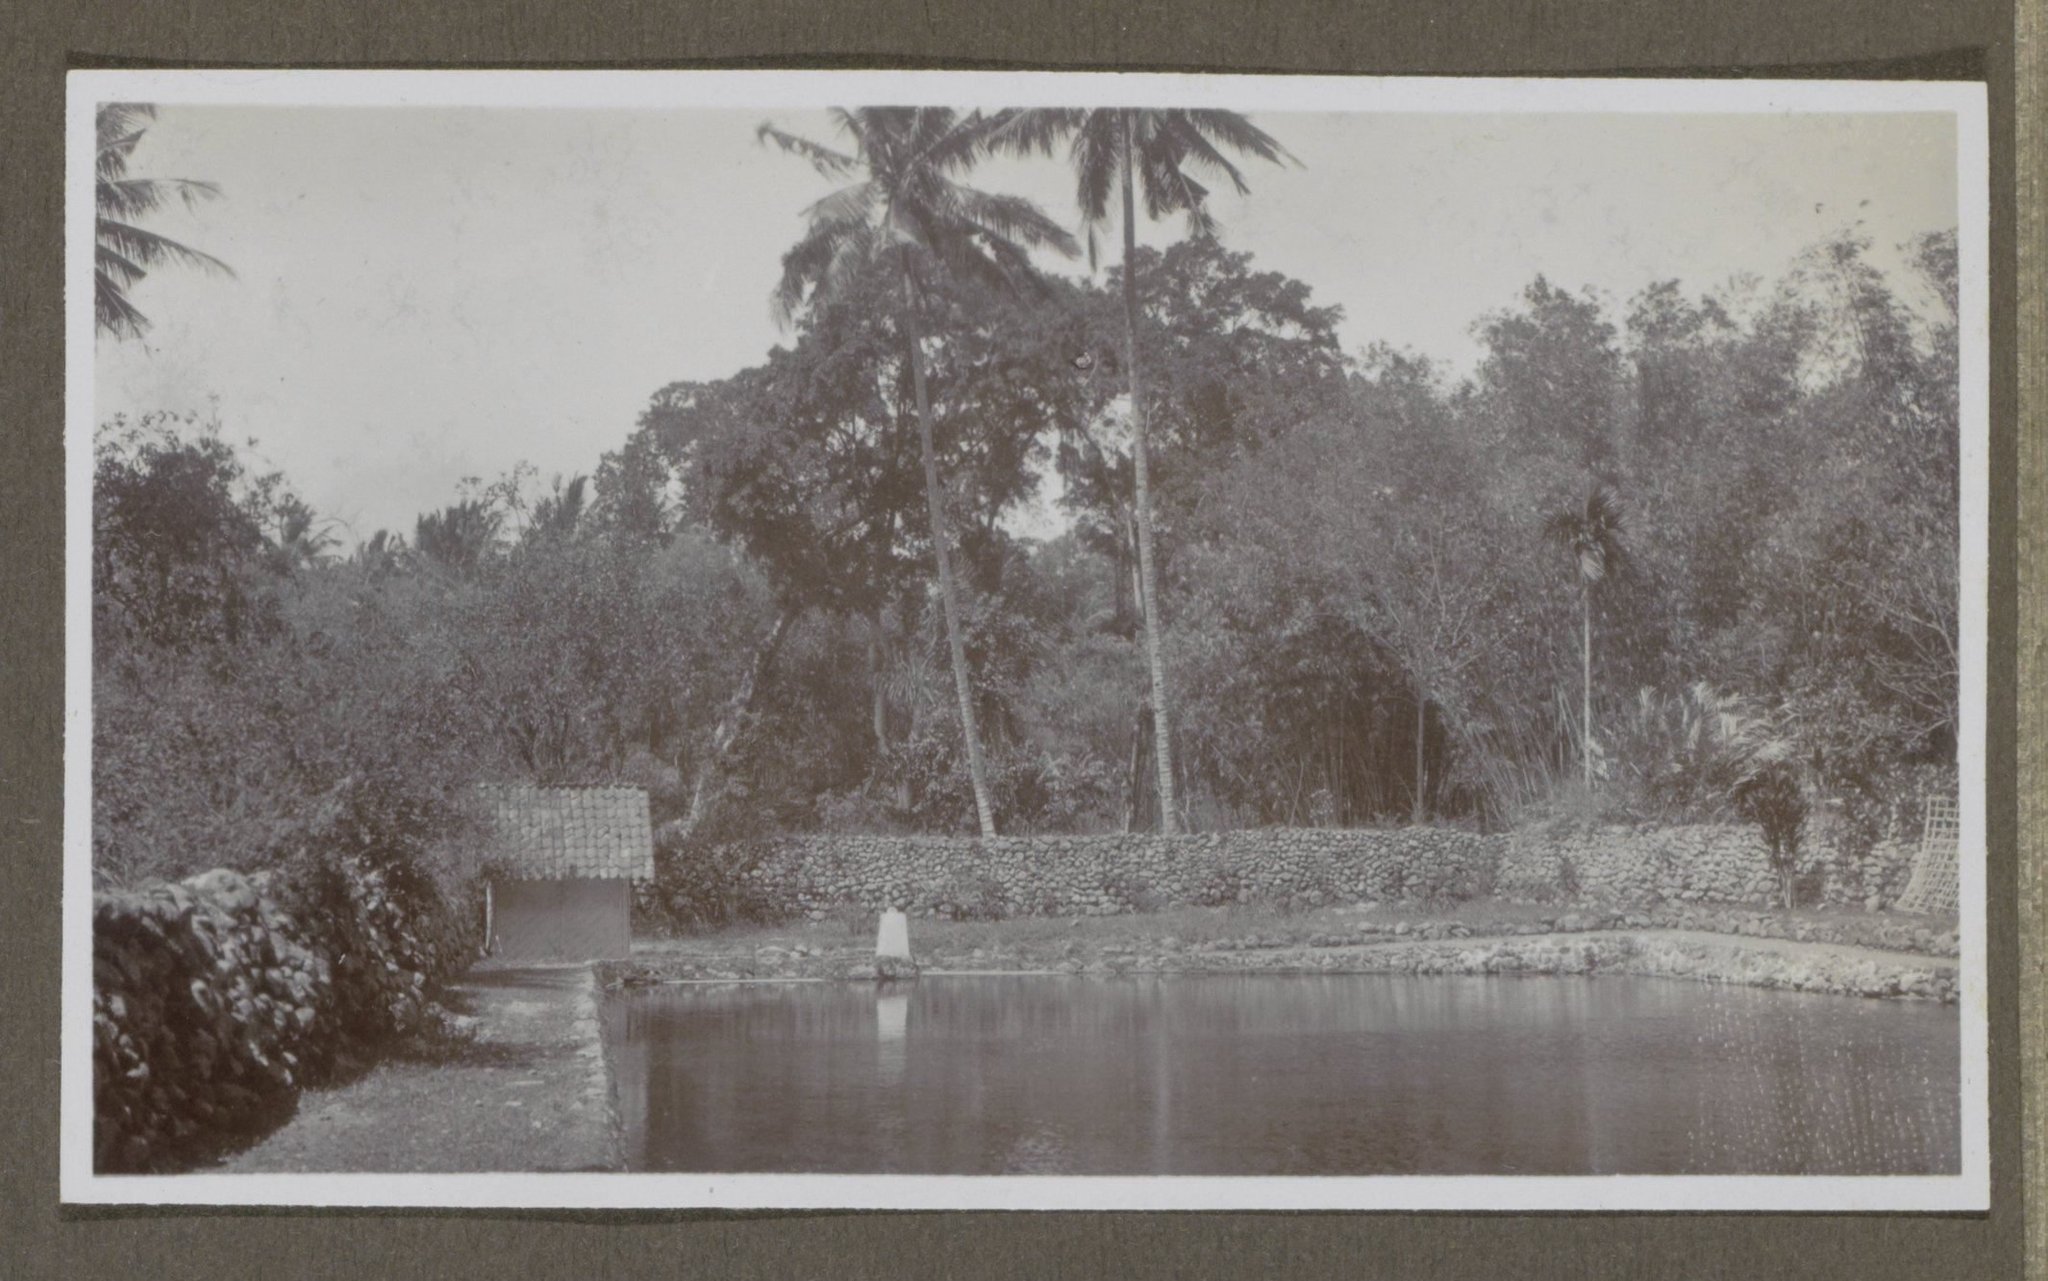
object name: photograph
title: Ommuurde vijver in een bosrijke omgeving, vermoedelijk behorend bij een horecagelegenheid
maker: Anonymous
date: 1920-1930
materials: photographic support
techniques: gelatin silver print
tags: garden pond, hotel, hostelry, inn, dutch east indies, the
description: Onderdeel van familiealbum Nederlands-Indië.